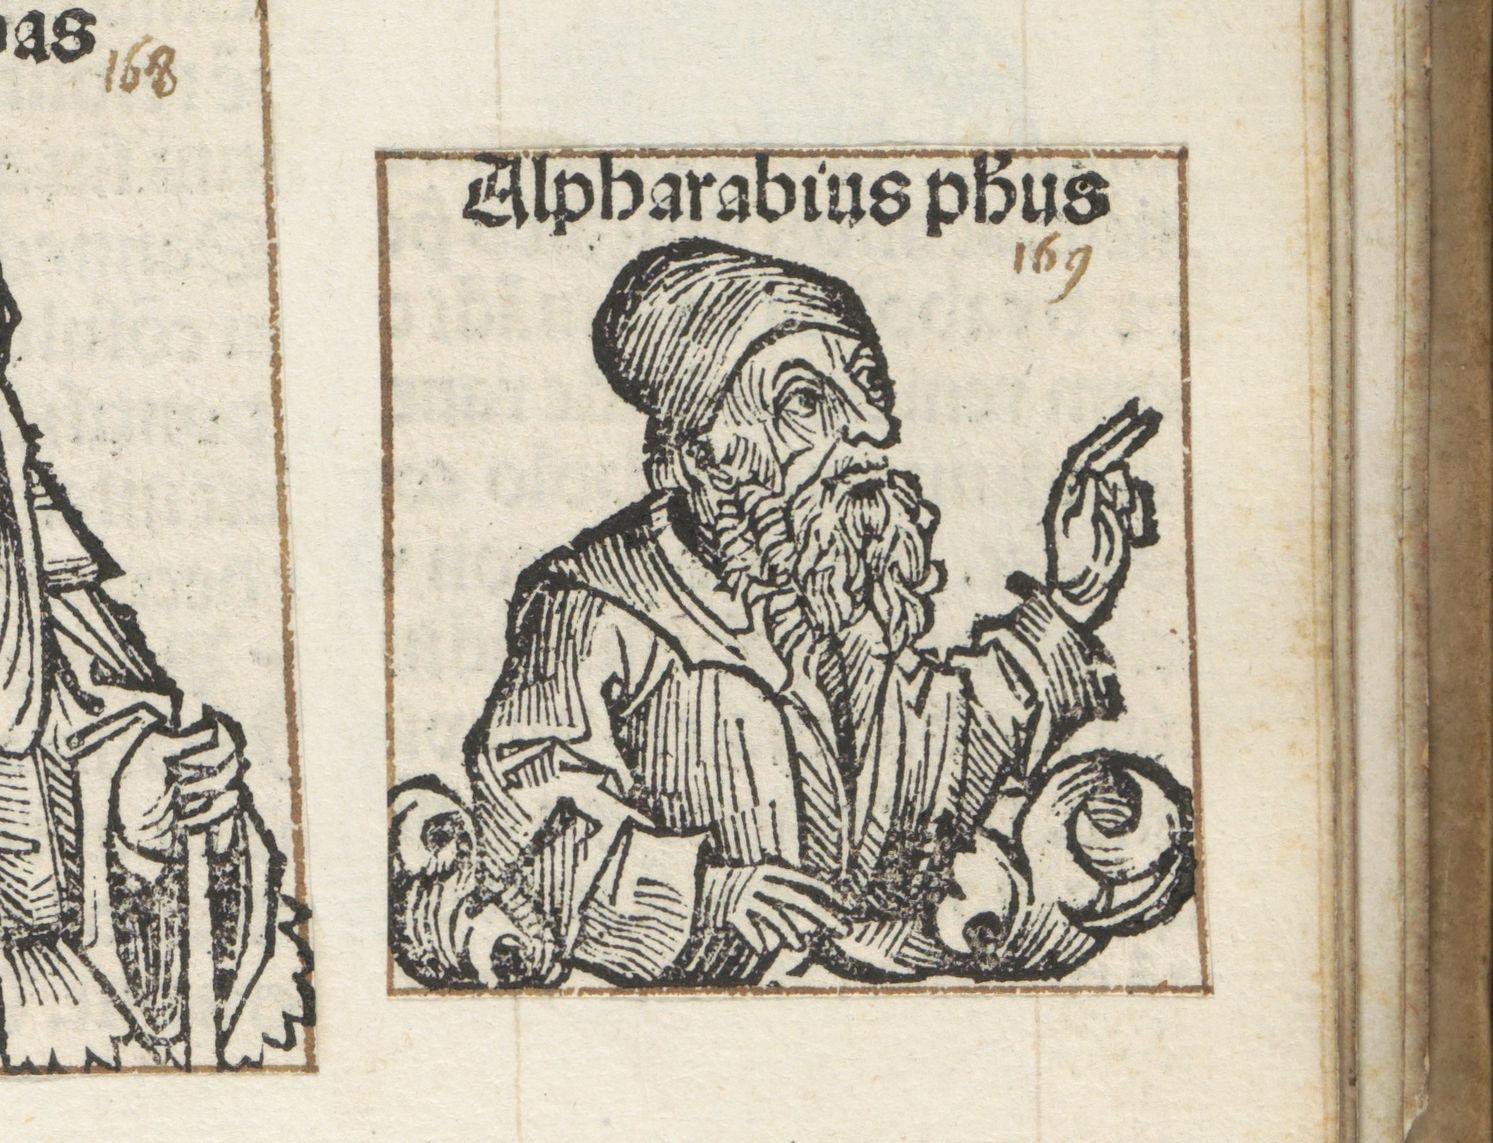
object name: album leaf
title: Al-Farabi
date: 1493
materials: paper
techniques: letterpress printing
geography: nuremberg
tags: filosoof, geleerde, al-farabi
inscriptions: inscription: ‘169’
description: De houtsnede wordt herhaaldelijk gebruikt als boekillustratie in de Liber Chronicarum (of Neurenbergkroniek) van Hartmann Schedel, verschenen in het Latijn en Duits in 1493. Zie de Latijnse uitgave, folio 181r.